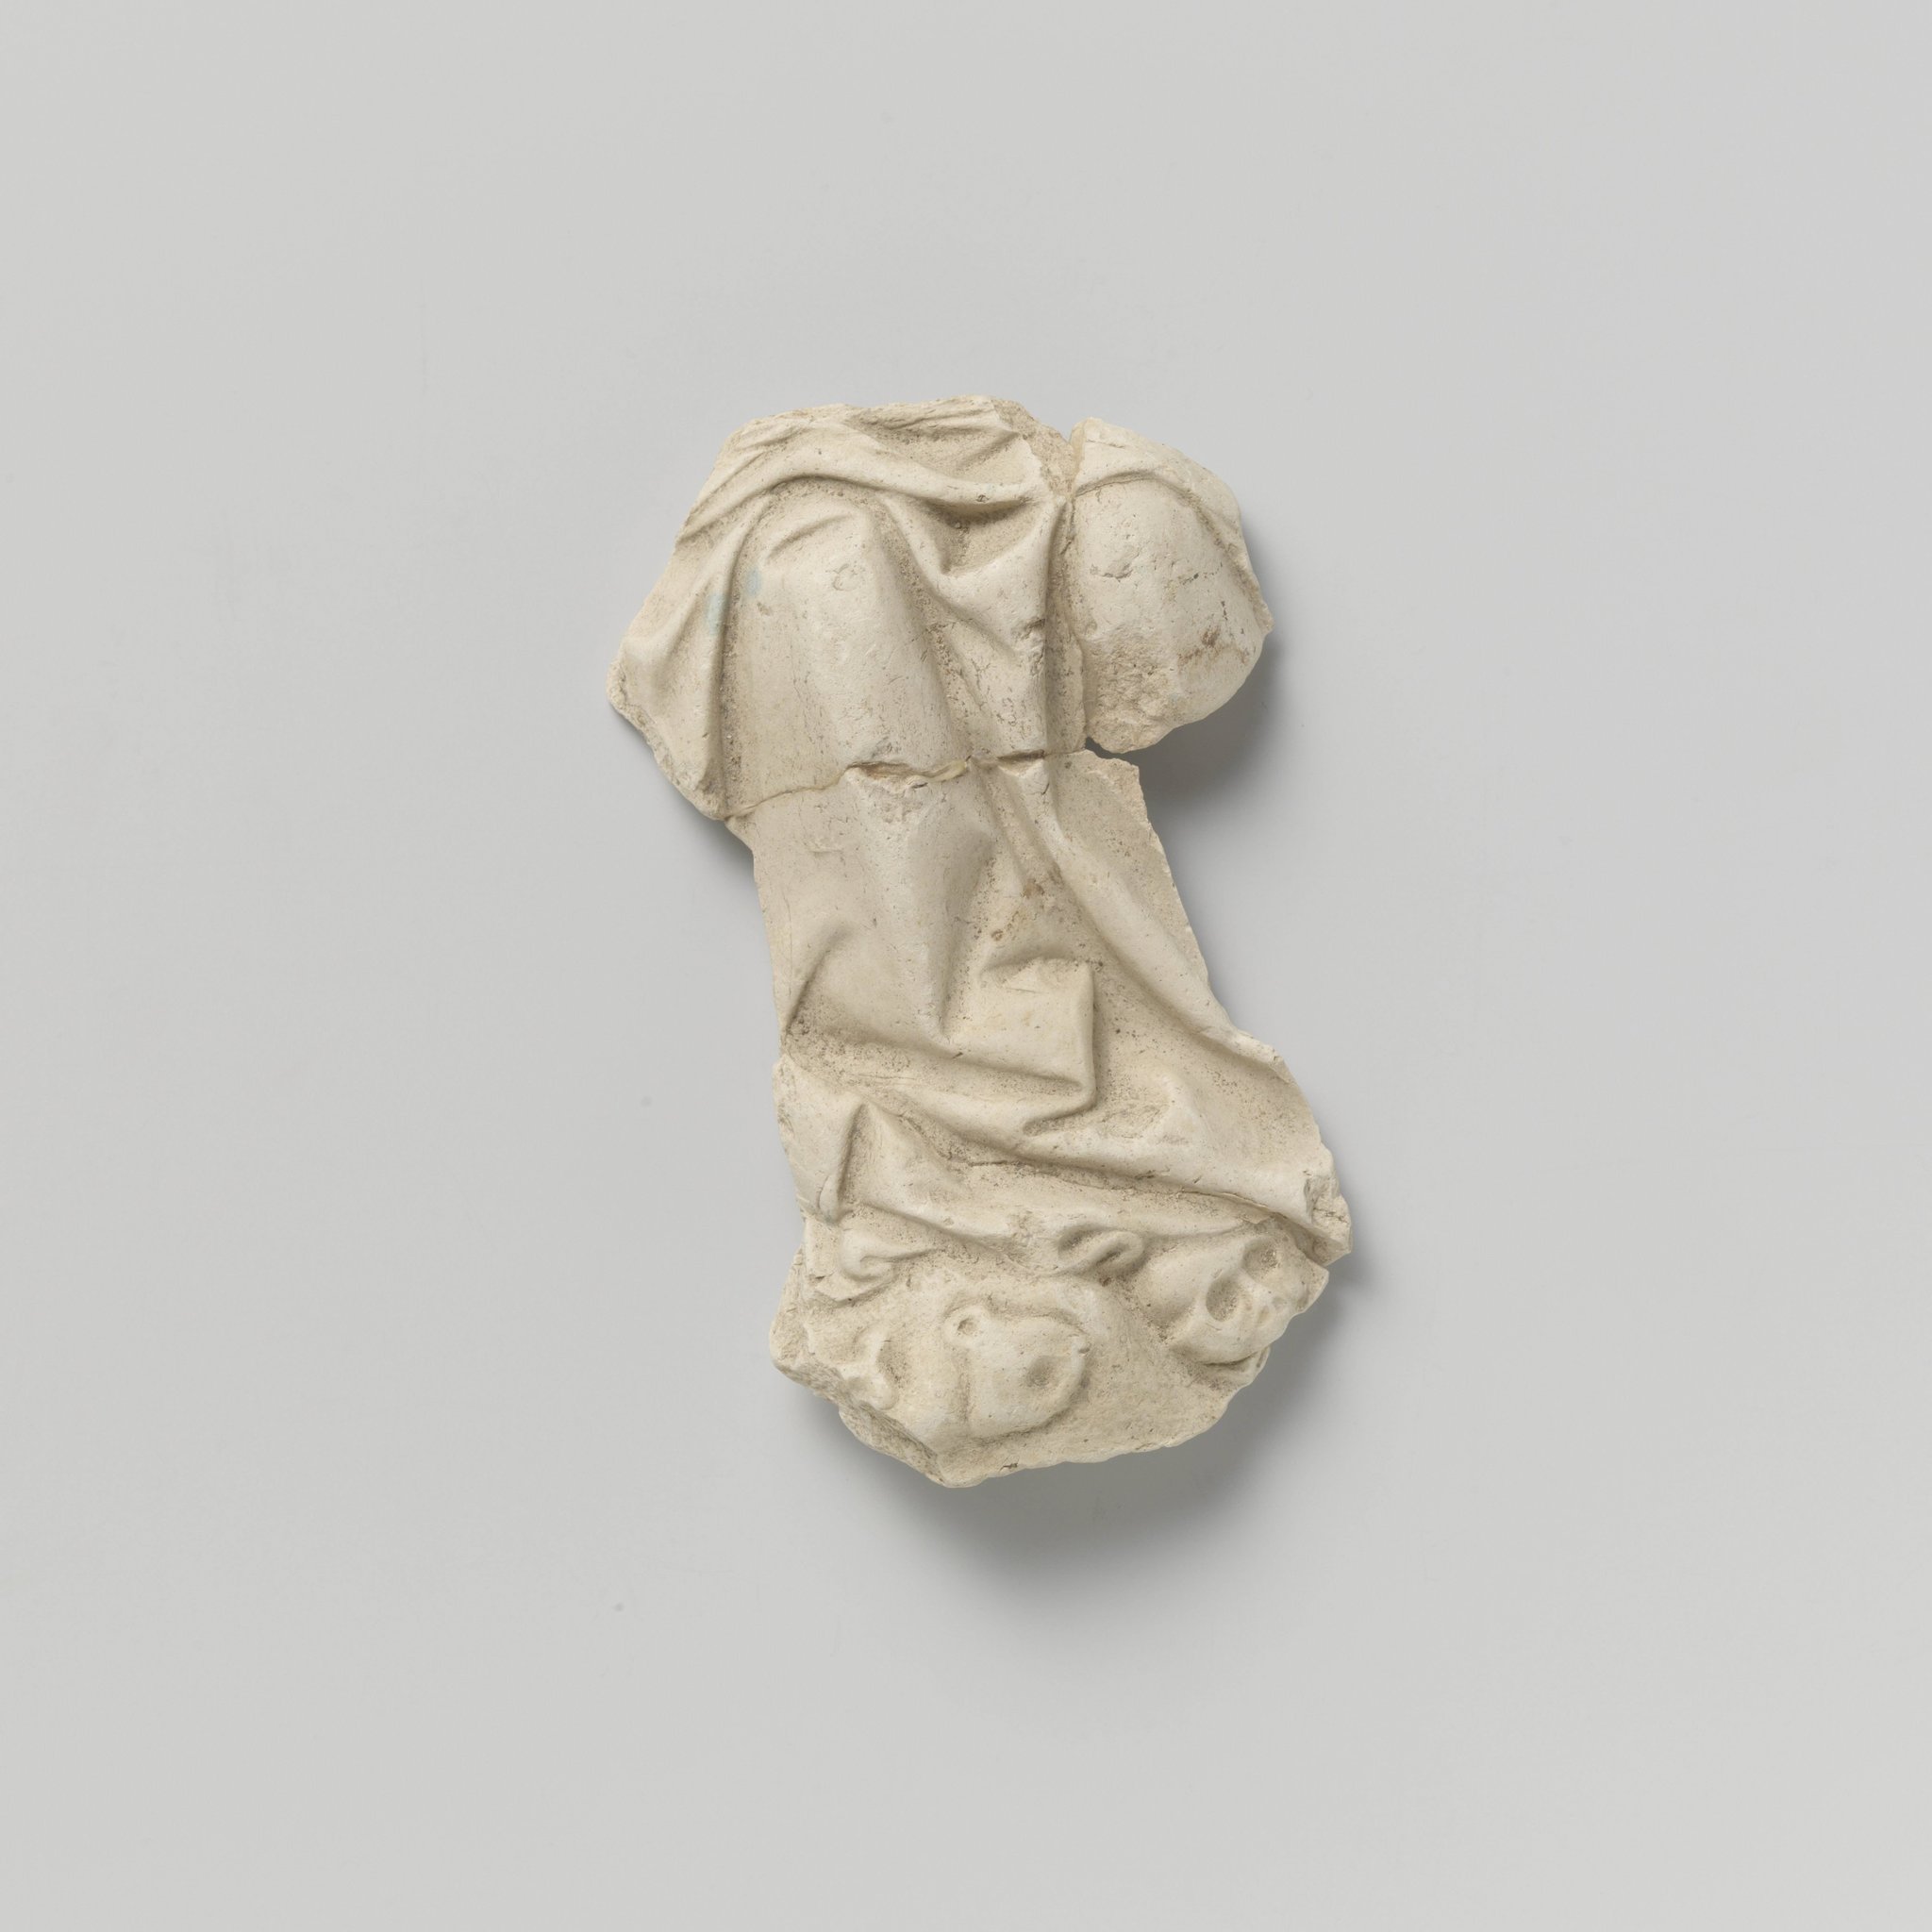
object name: sculpture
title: Pietà, Fragment with Mary’s Lower Legs and a Skull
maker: Anonymous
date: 1460-1480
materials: clay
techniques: modeling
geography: northern netherlands